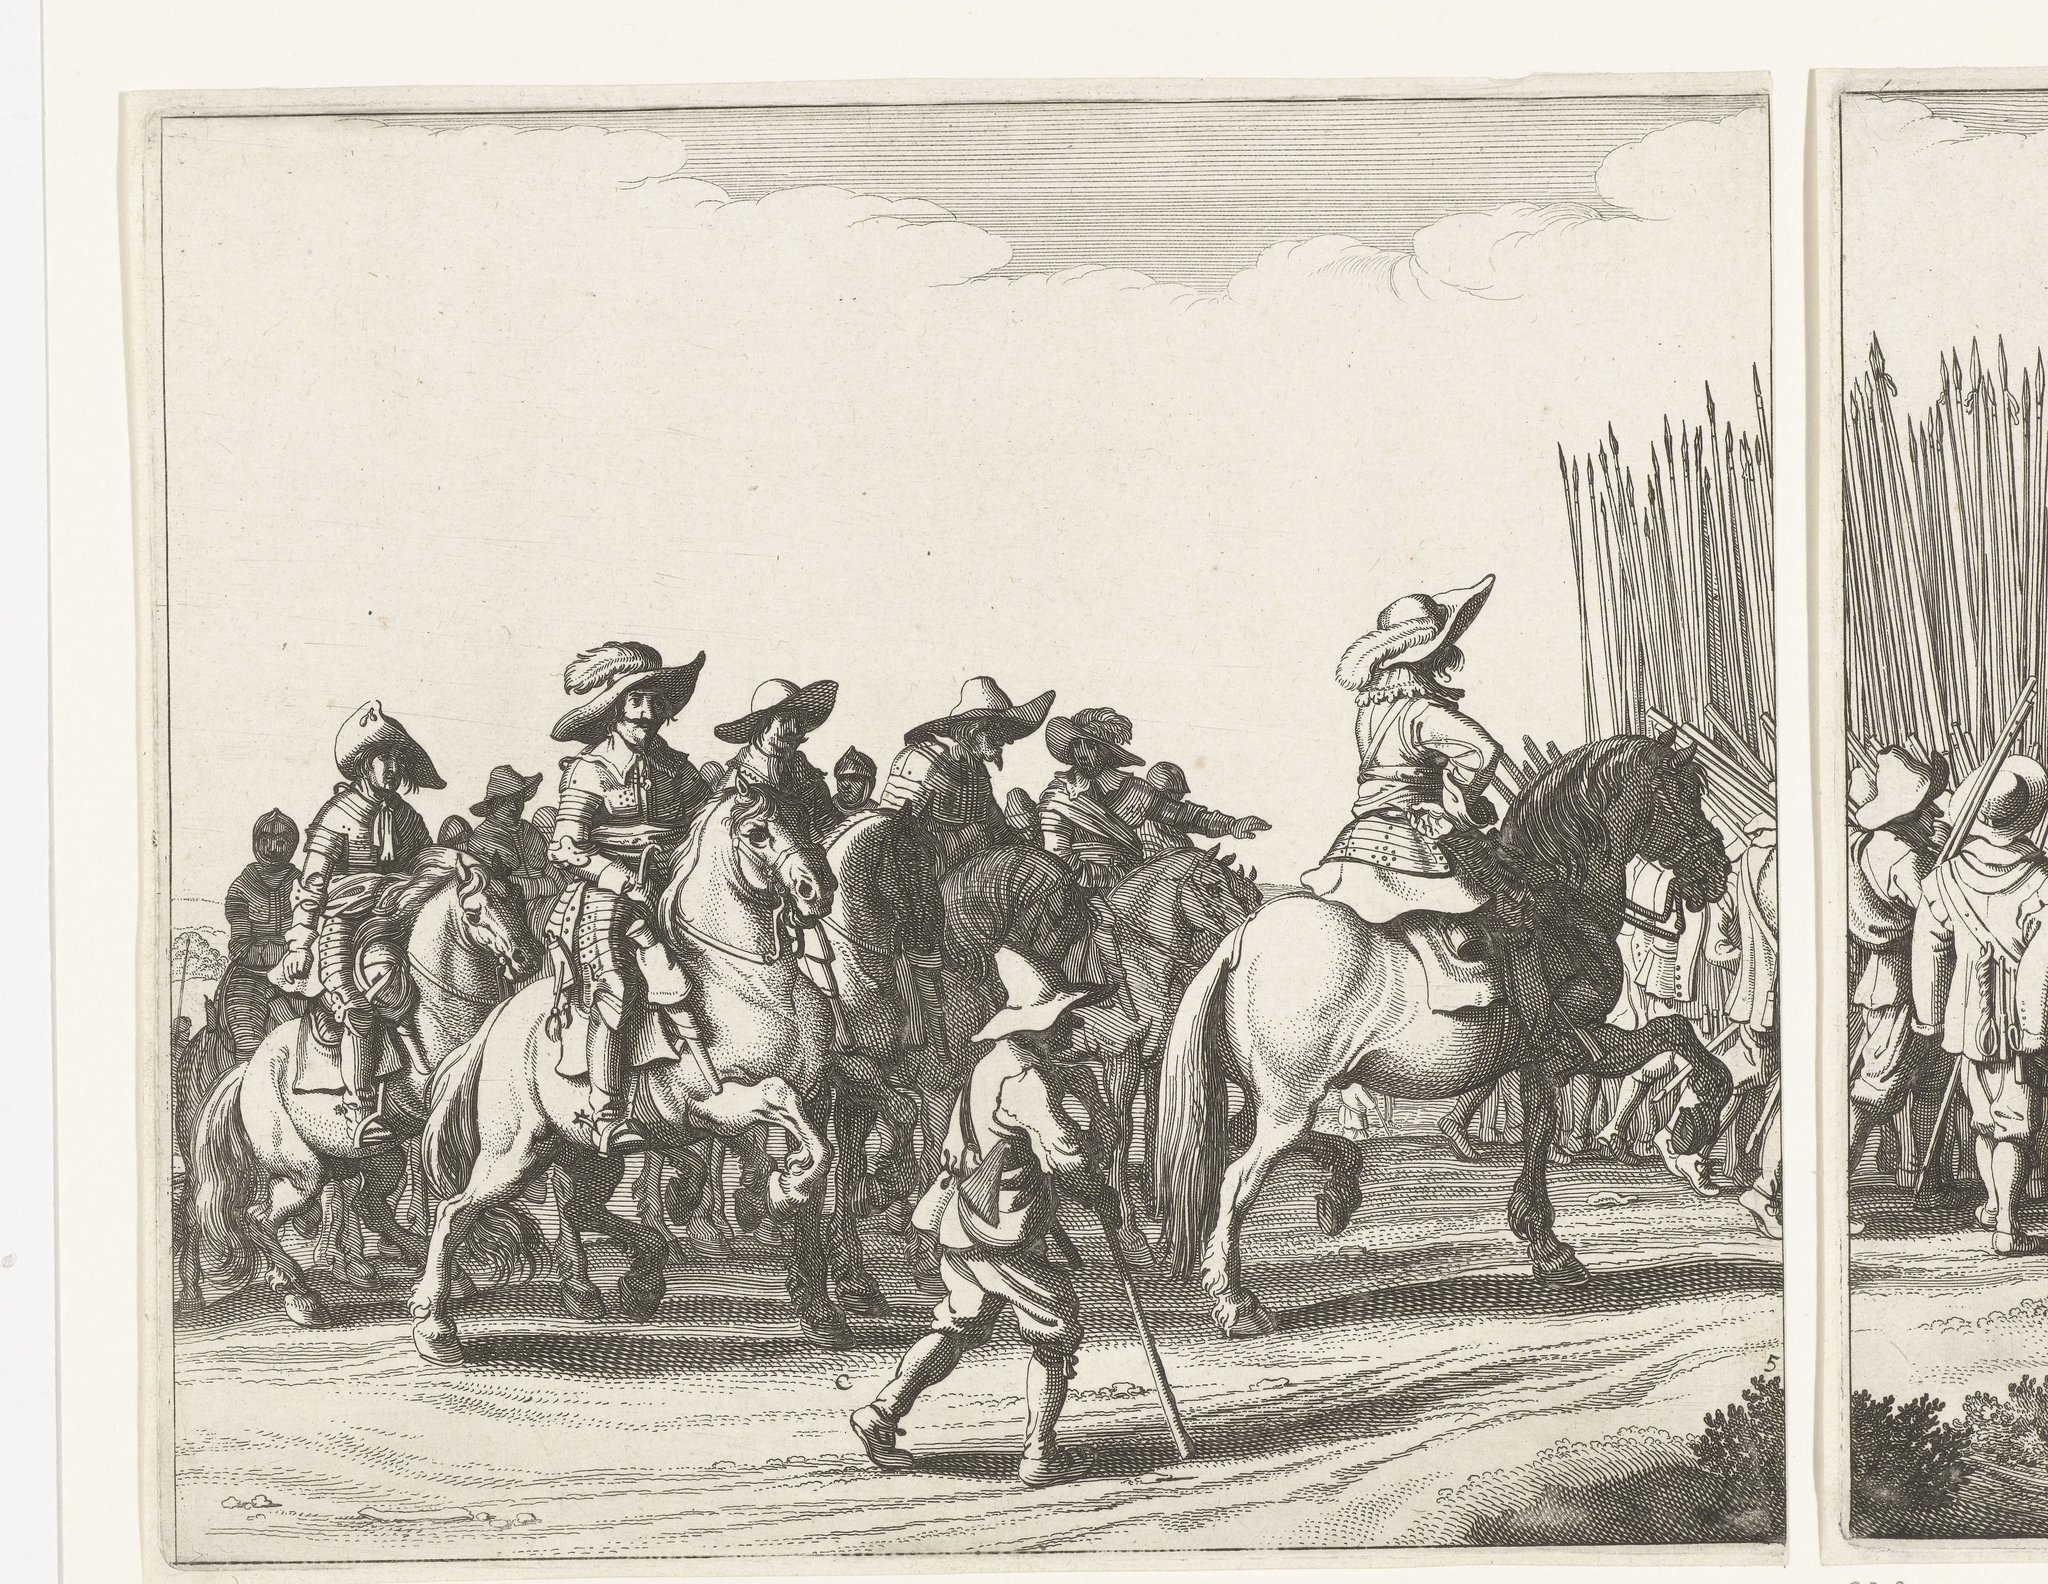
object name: print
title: Uittocht van het Spaanse leger uit Maastricht, 1632 (plaat 5)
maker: jan van de velde (ii)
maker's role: draughtsman, painter, print maker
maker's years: 1593-1641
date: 1633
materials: paper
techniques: etching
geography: northern netherlands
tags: frederick henry (prince of orange), retreat of the defeated, maastricht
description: Uittocht van het Spaanse leger uit Maastricht, 23 augustus 1632. Fries van zes genummerd platen, plaat nr. 5. De cavalerie van het vertrekkende leger.